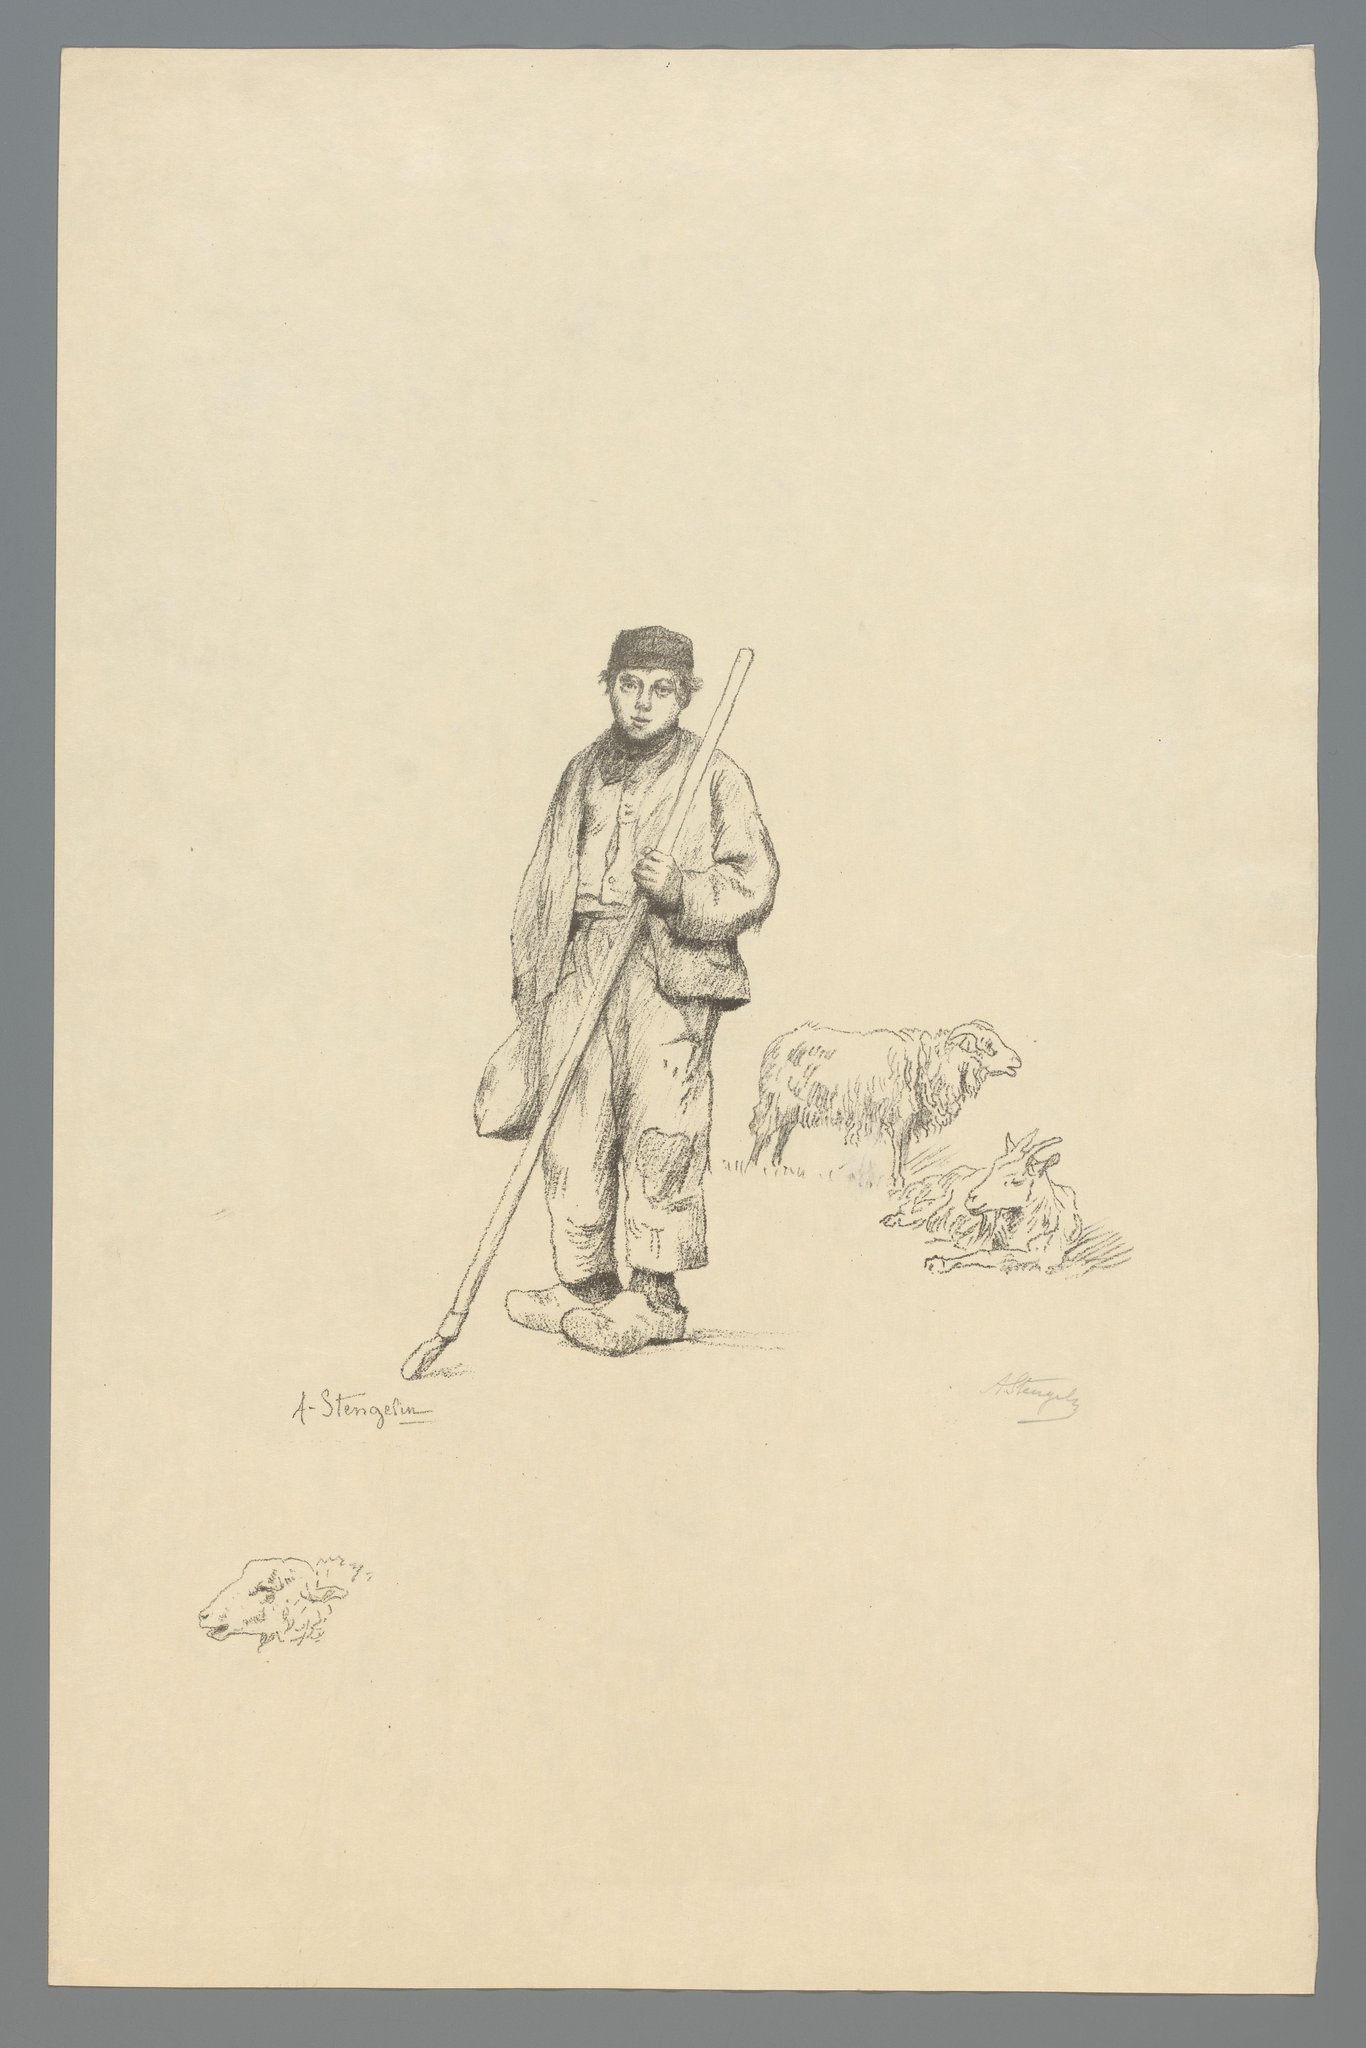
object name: print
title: Herdersjongen met geit en schaap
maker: alphonse stengelin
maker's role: painter, print maker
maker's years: 1852-1938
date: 1876-1910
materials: paper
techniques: lithograph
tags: herding, herdsman, herdswoman, shepherd, shepherdess, cowherd, etc.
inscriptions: collector's mark: Lugt 2228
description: Linksonder een remarque met een schapenkop.